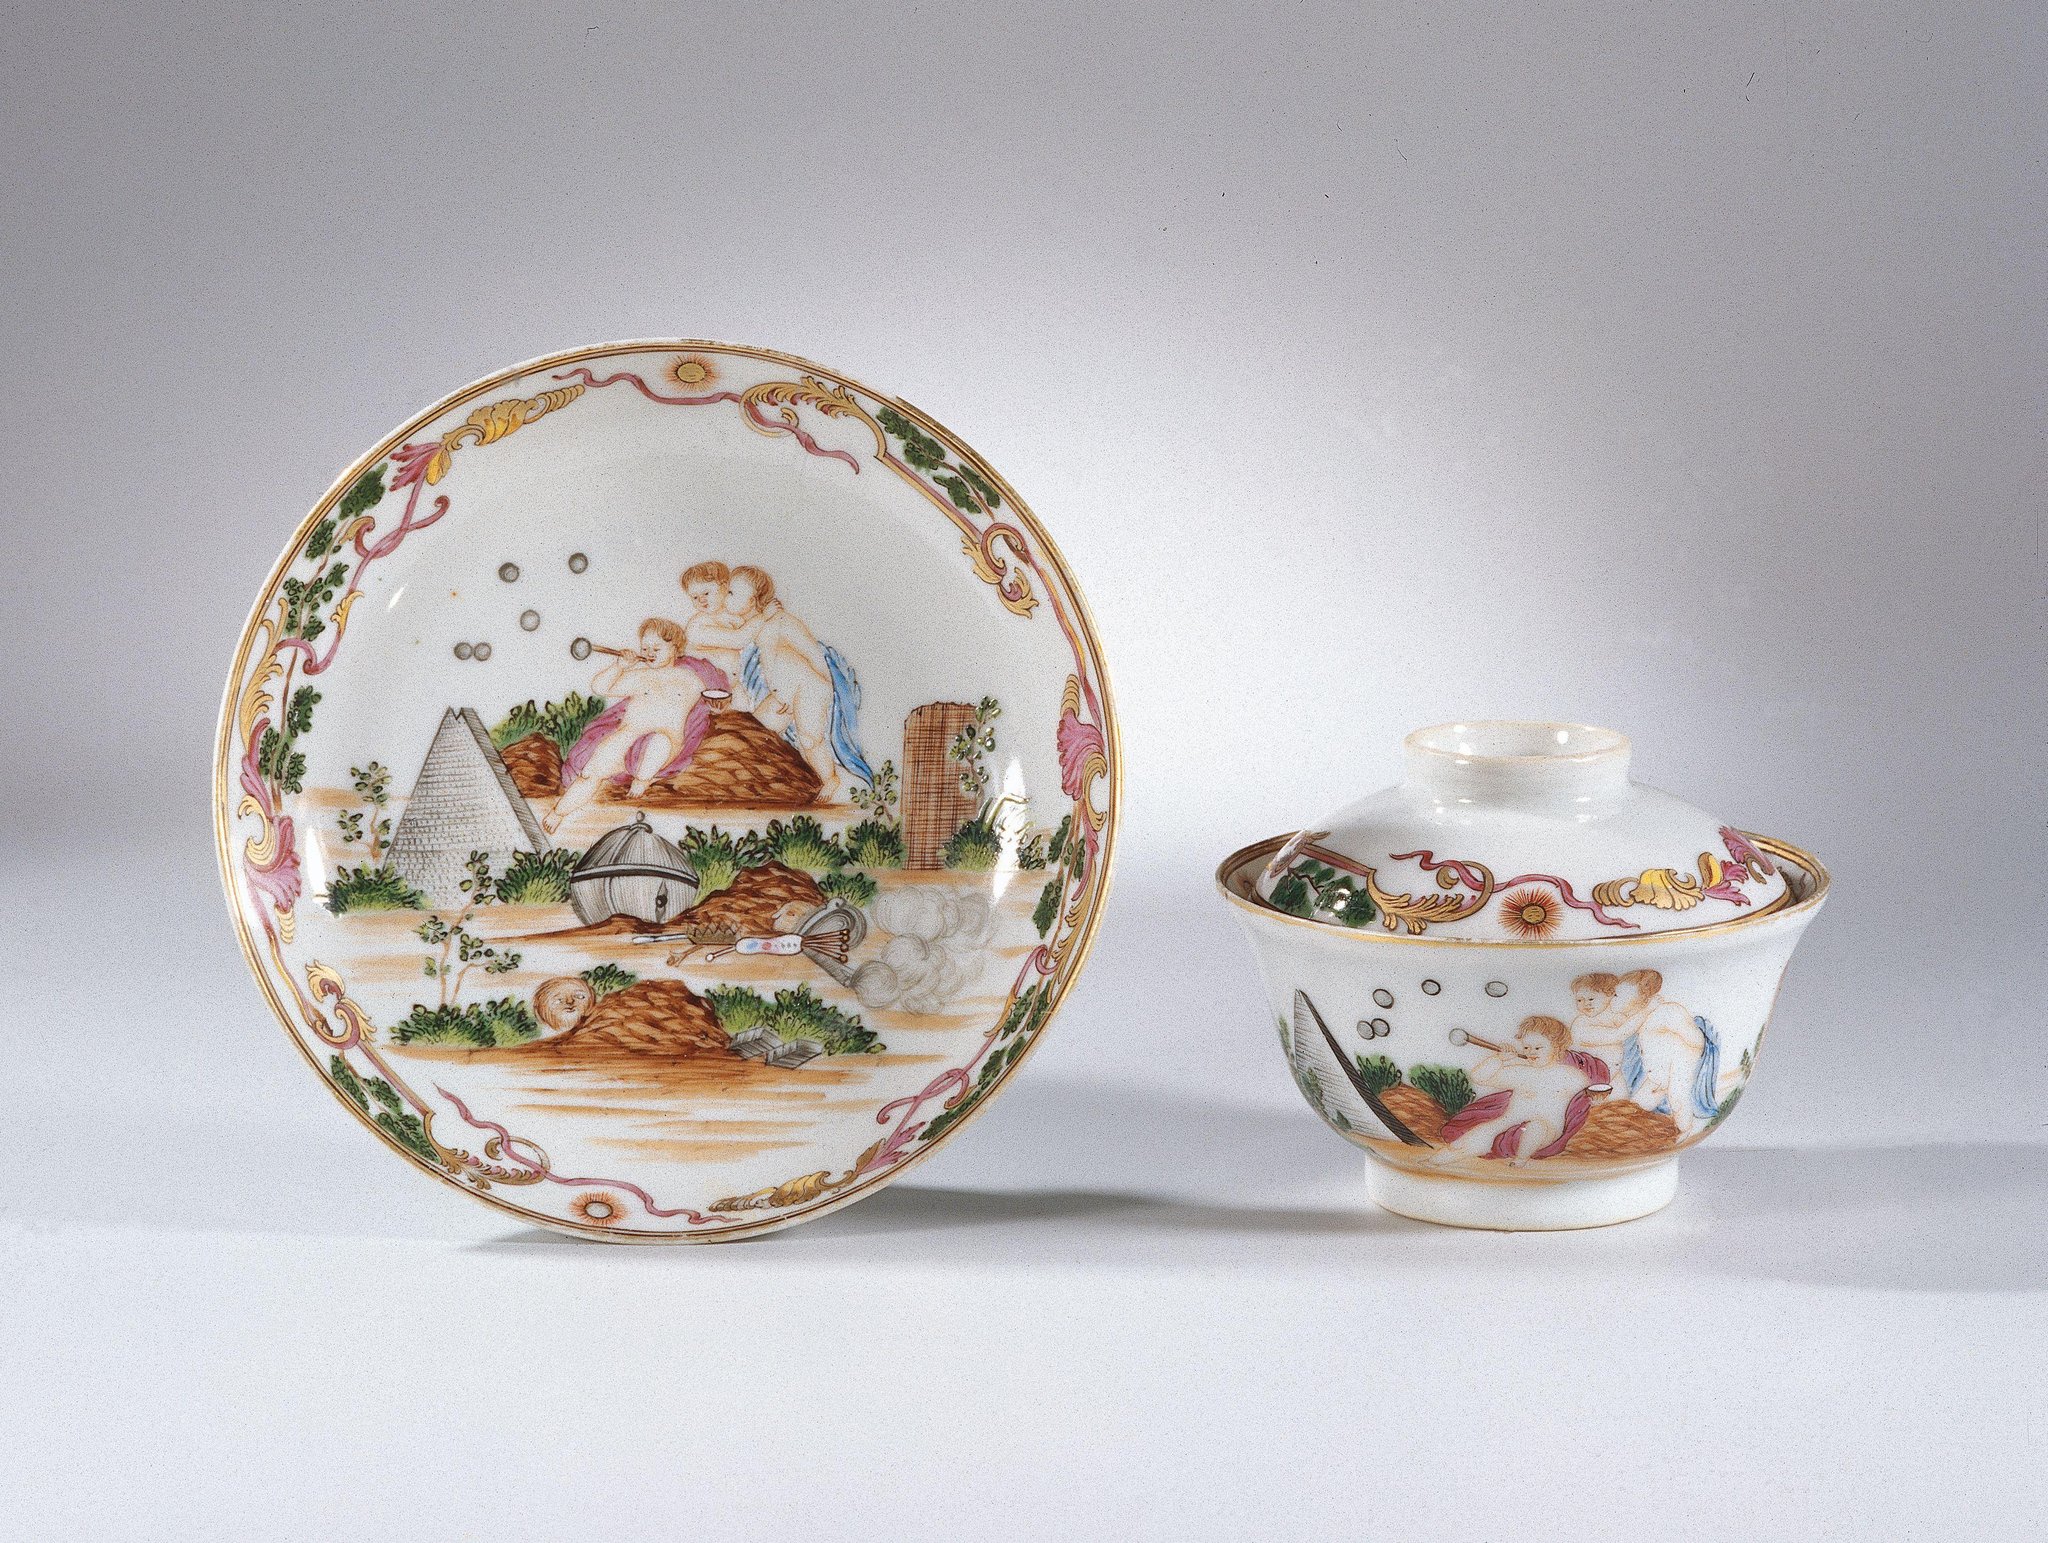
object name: cup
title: Bell-shaped covered cup with a symbolic image of three putti and different objects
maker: Anonymous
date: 1750-1760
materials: glaze, gold, paint, porcelain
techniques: firing, gilding, turning, vitrification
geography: amsterdam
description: Kop met deksel en schotel op een voetring, de deksel met een ronde ringknop. Gedecoreerd in polychrome emailkleuren met drie putti in een landschap. Een van de putti blaast zeepbellen door een pijpje. Vóór de putti een piramide, een masker en andere objecten. Op de randen bloem- en bladranken. Boven en onder in de rand is een zon afgebeeld voorzien van een gezicht. De deksel heeft een eigen inventarisnummer: AK-NM-13814. De voorstelling lijkt sterk op een tekening van de schilder Jacob de Wit (1695-1754) met de titel 'Allegorie op de vergankelijkheid'. Op de tekening zijn de voorwerpen makkelijk te herkennen als een kroon, een doodskop, een schilderspalet, boeken, een masker en een globe. Samen met de bellenblazende putti staat de voorstelling symbool voor de vergankelijkheid van het leven, de wereldlijke macht, van bouwwerken, de kunst en de wetenschap. De voorstelling op de schotel en de voorstelling op de tekening komt niet op alle punten overeen. Op het porselein loopt de piramide wat verder door, op de tekening is de piramide aan de top afgebroken. Op de tekening is de piramide opgebouwd uit grote blokken, terwijl dat op het porselein niet te zien is. Op de prent houdt de bellenblazende putto zijn arm gestrekt, maar op het porselein is de arm van de putto gebogen. Het ligt niet voor de hand dat de Chinese porseleinschilder de veranderingen zelf heeft aangebracht, en daarom zal waarschijnlijk niet deze, maar een andere tekening als voorbeeld hebben gediend, wellicht een kopie naar de tekening van de Wit, speciaal vervaardigd om als voorbeeld naar China te worden meegenomen.